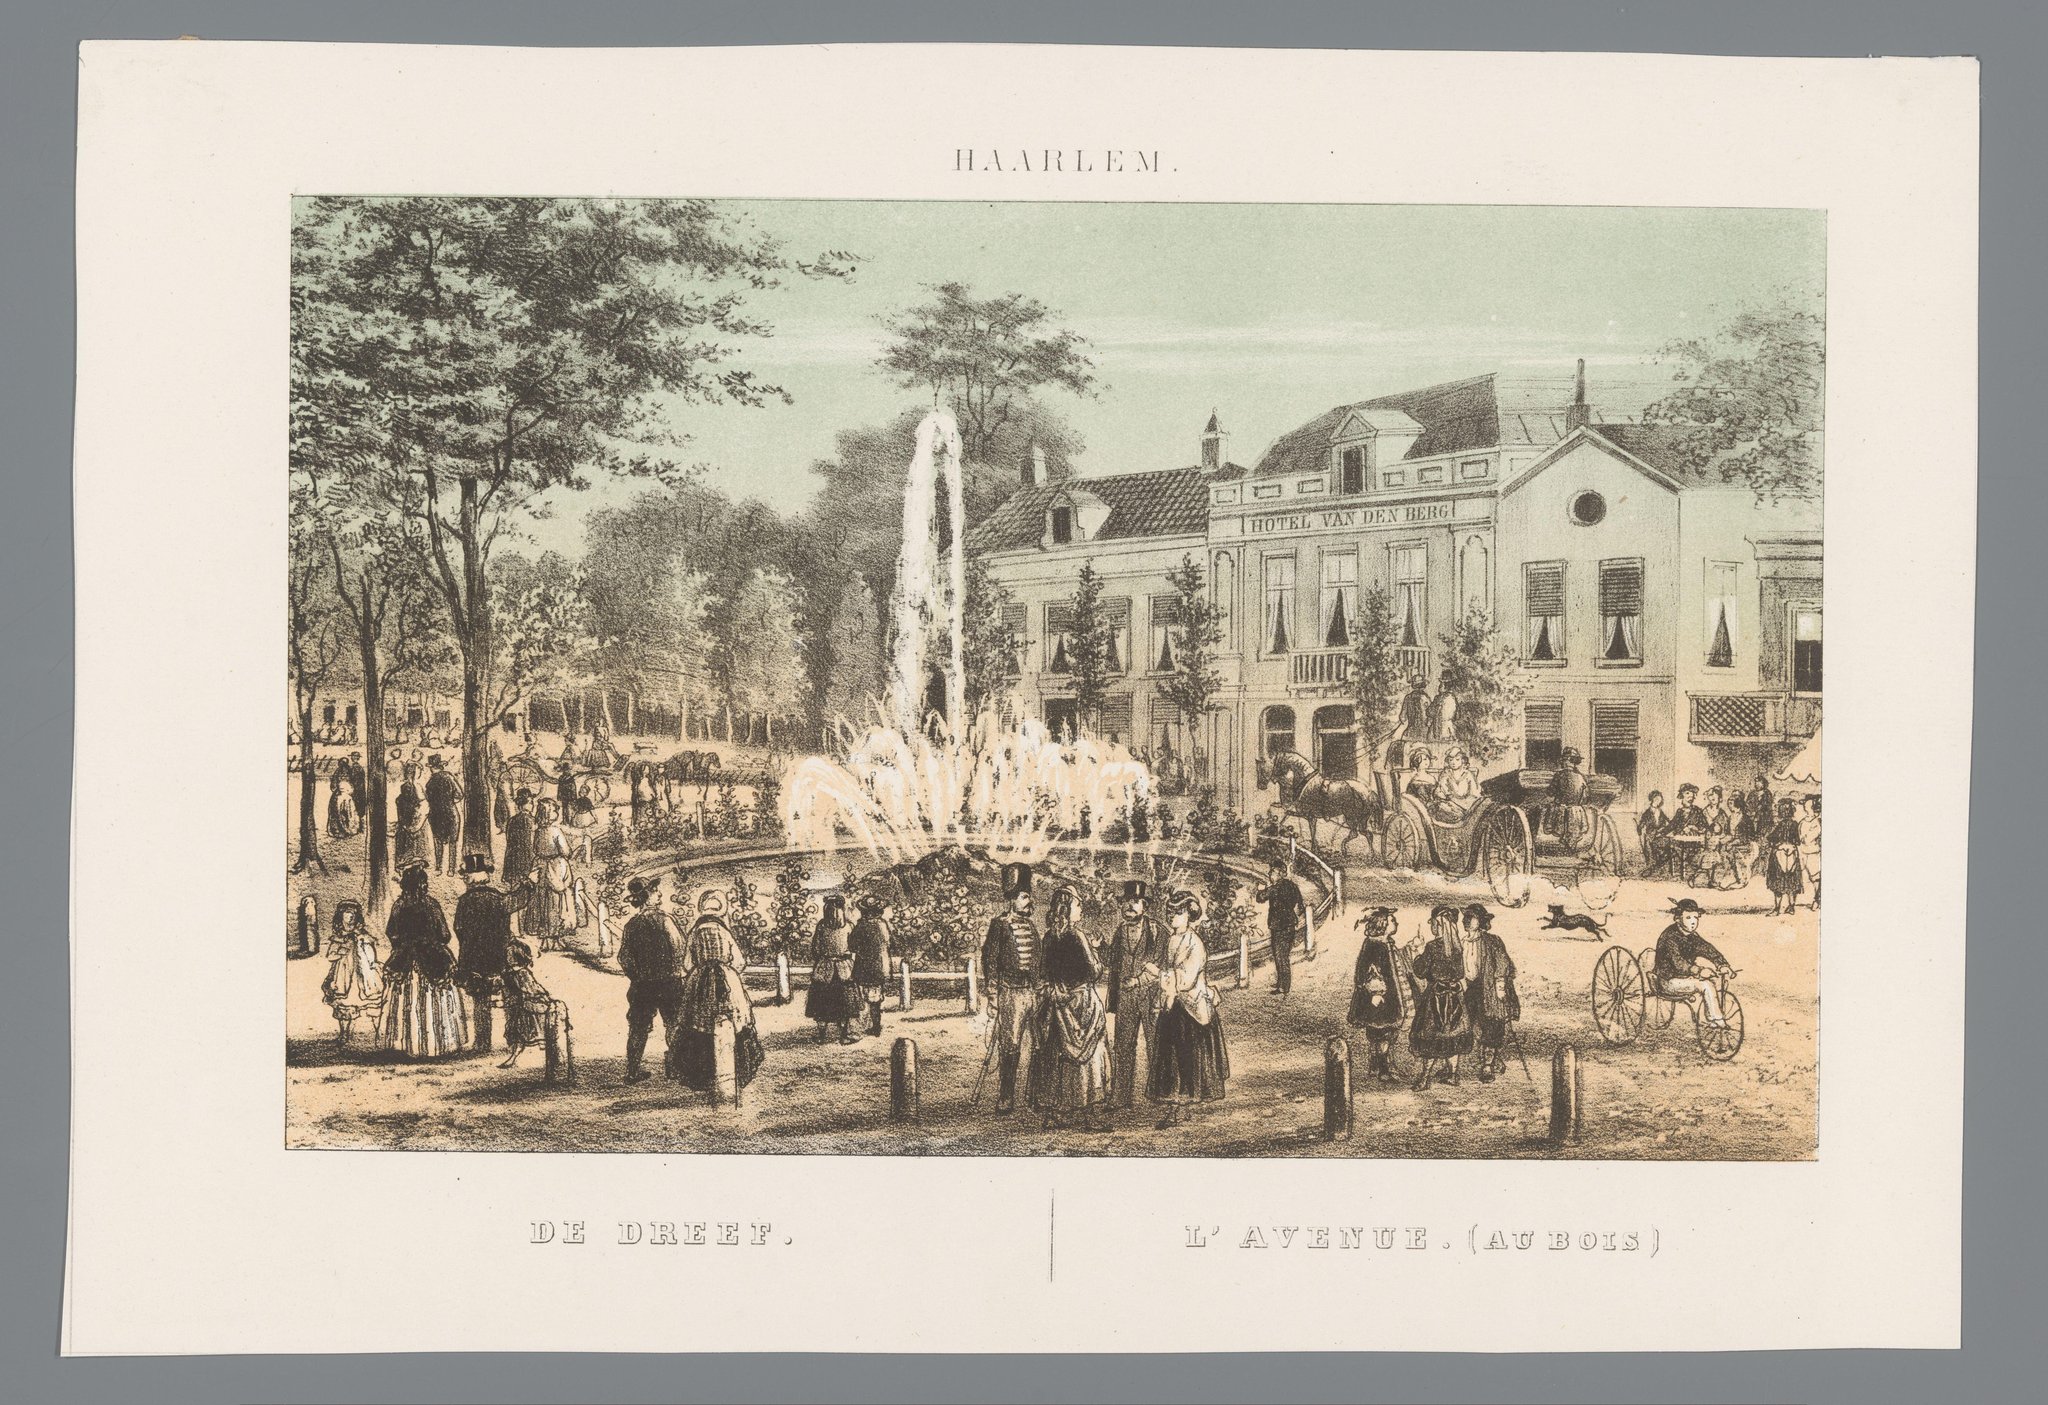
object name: print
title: Gezicht op de Dreef in Haarlem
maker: Anonymous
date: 1850-1900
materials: paper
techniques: tone lithography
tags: tricycle, ornamental fountain, four-wheeled vehicle drawn by two animals, haarlem